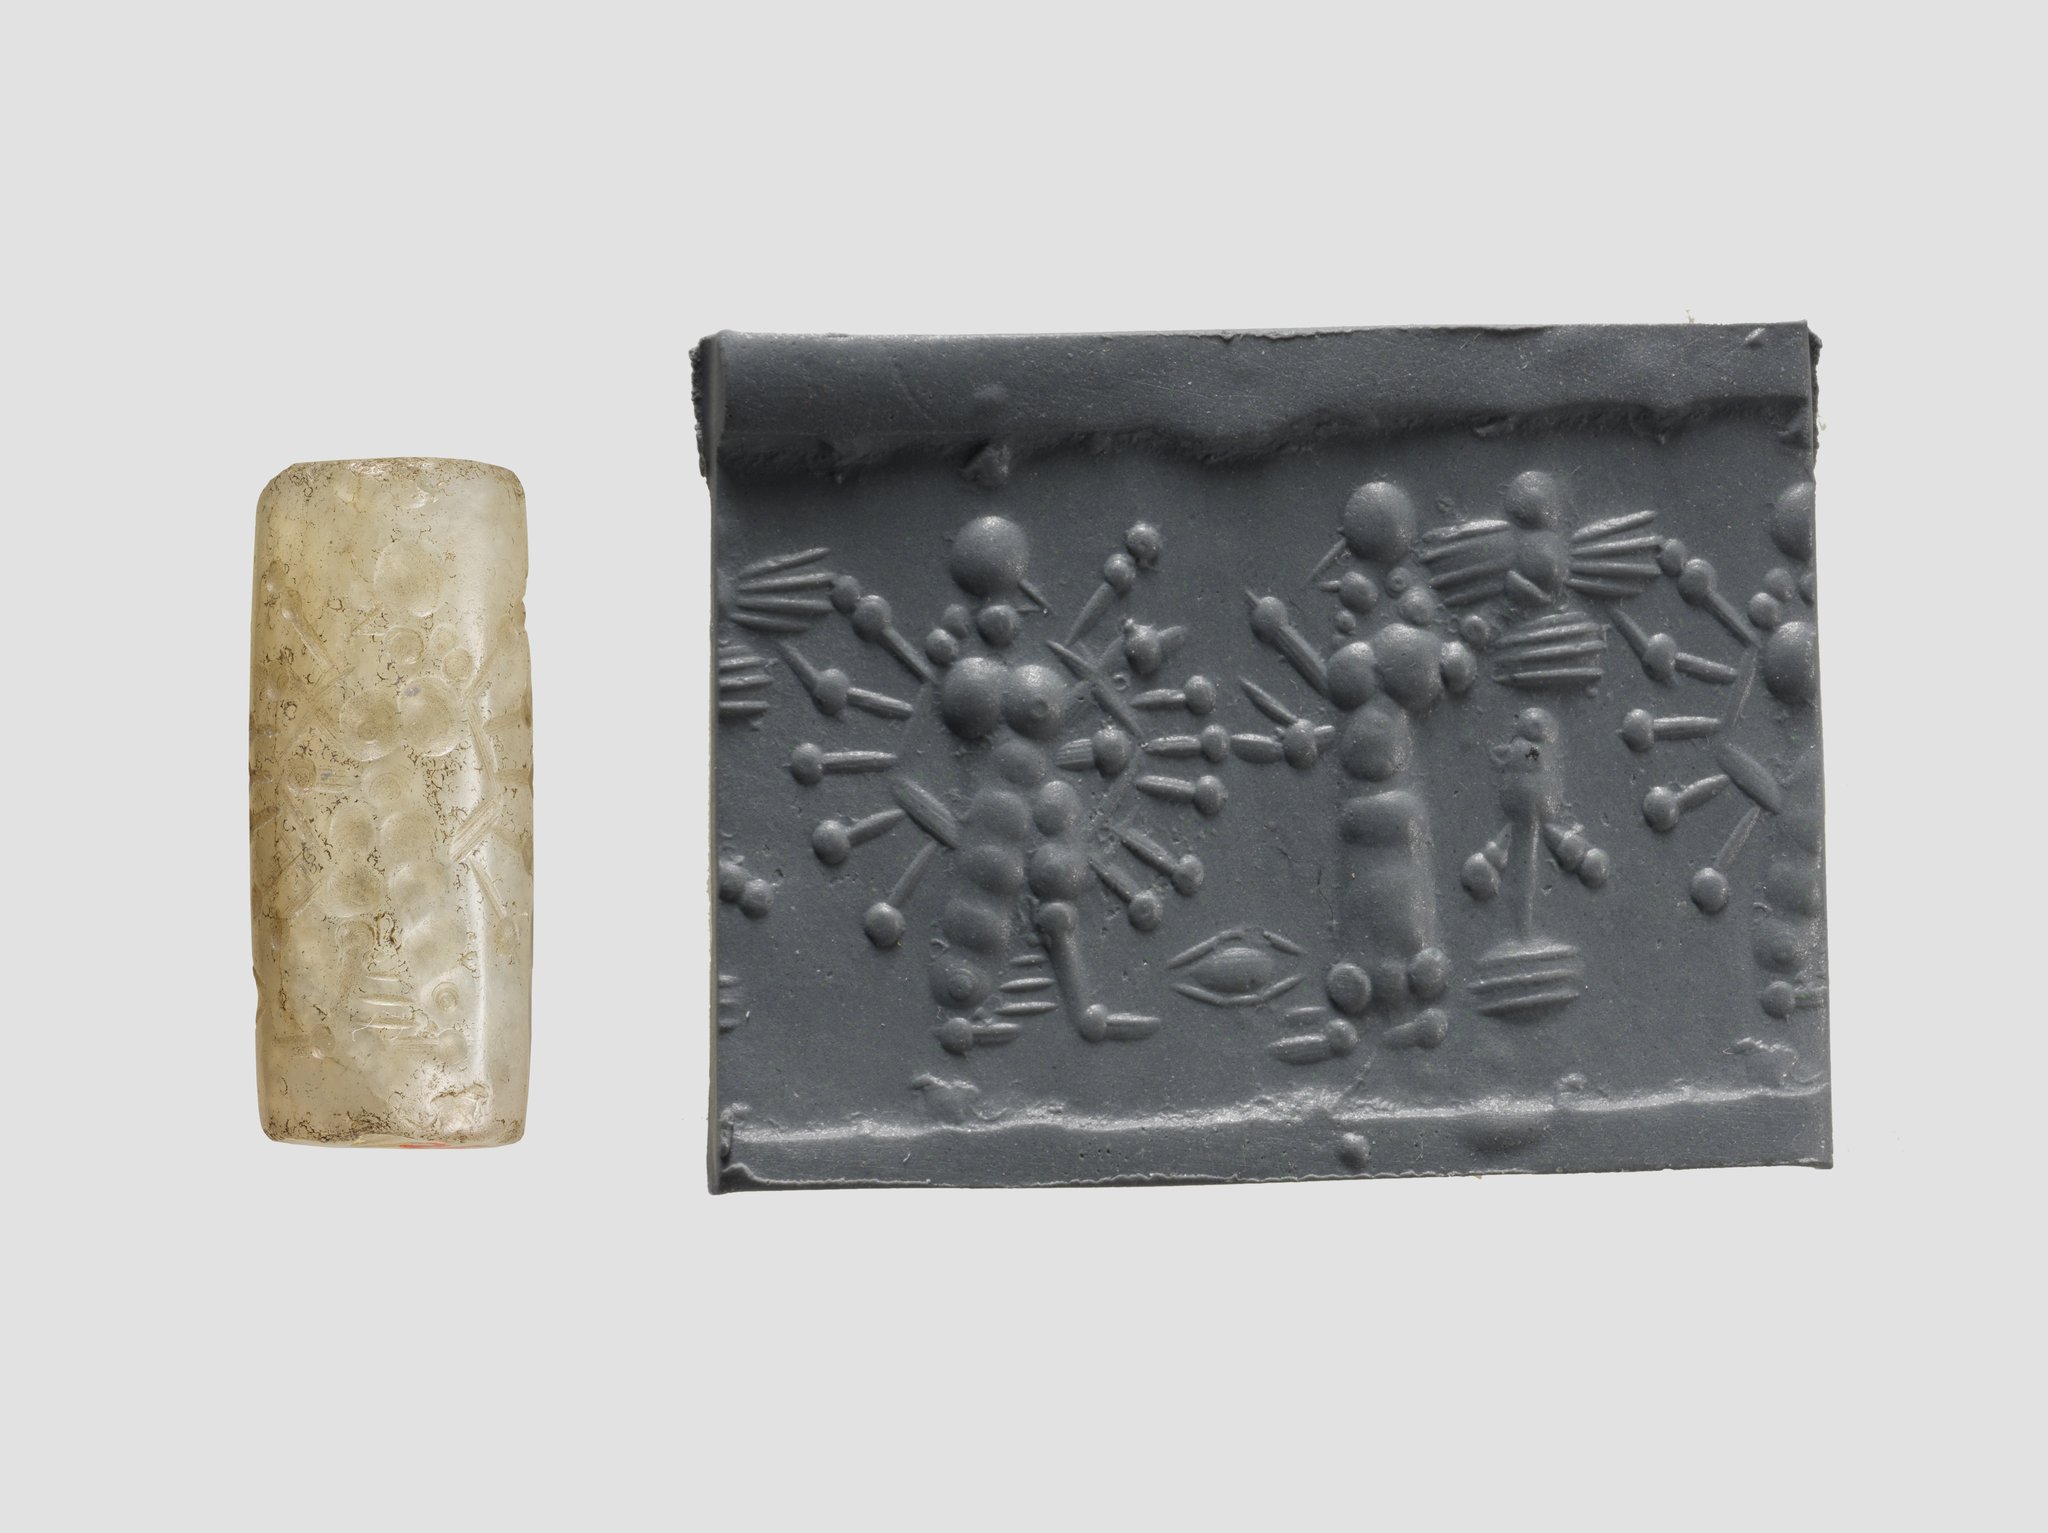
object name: cylinder seal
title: Cylinder seal with cultic scene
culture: assyrian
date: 700-601 BCE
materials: stone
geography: mesopotamia